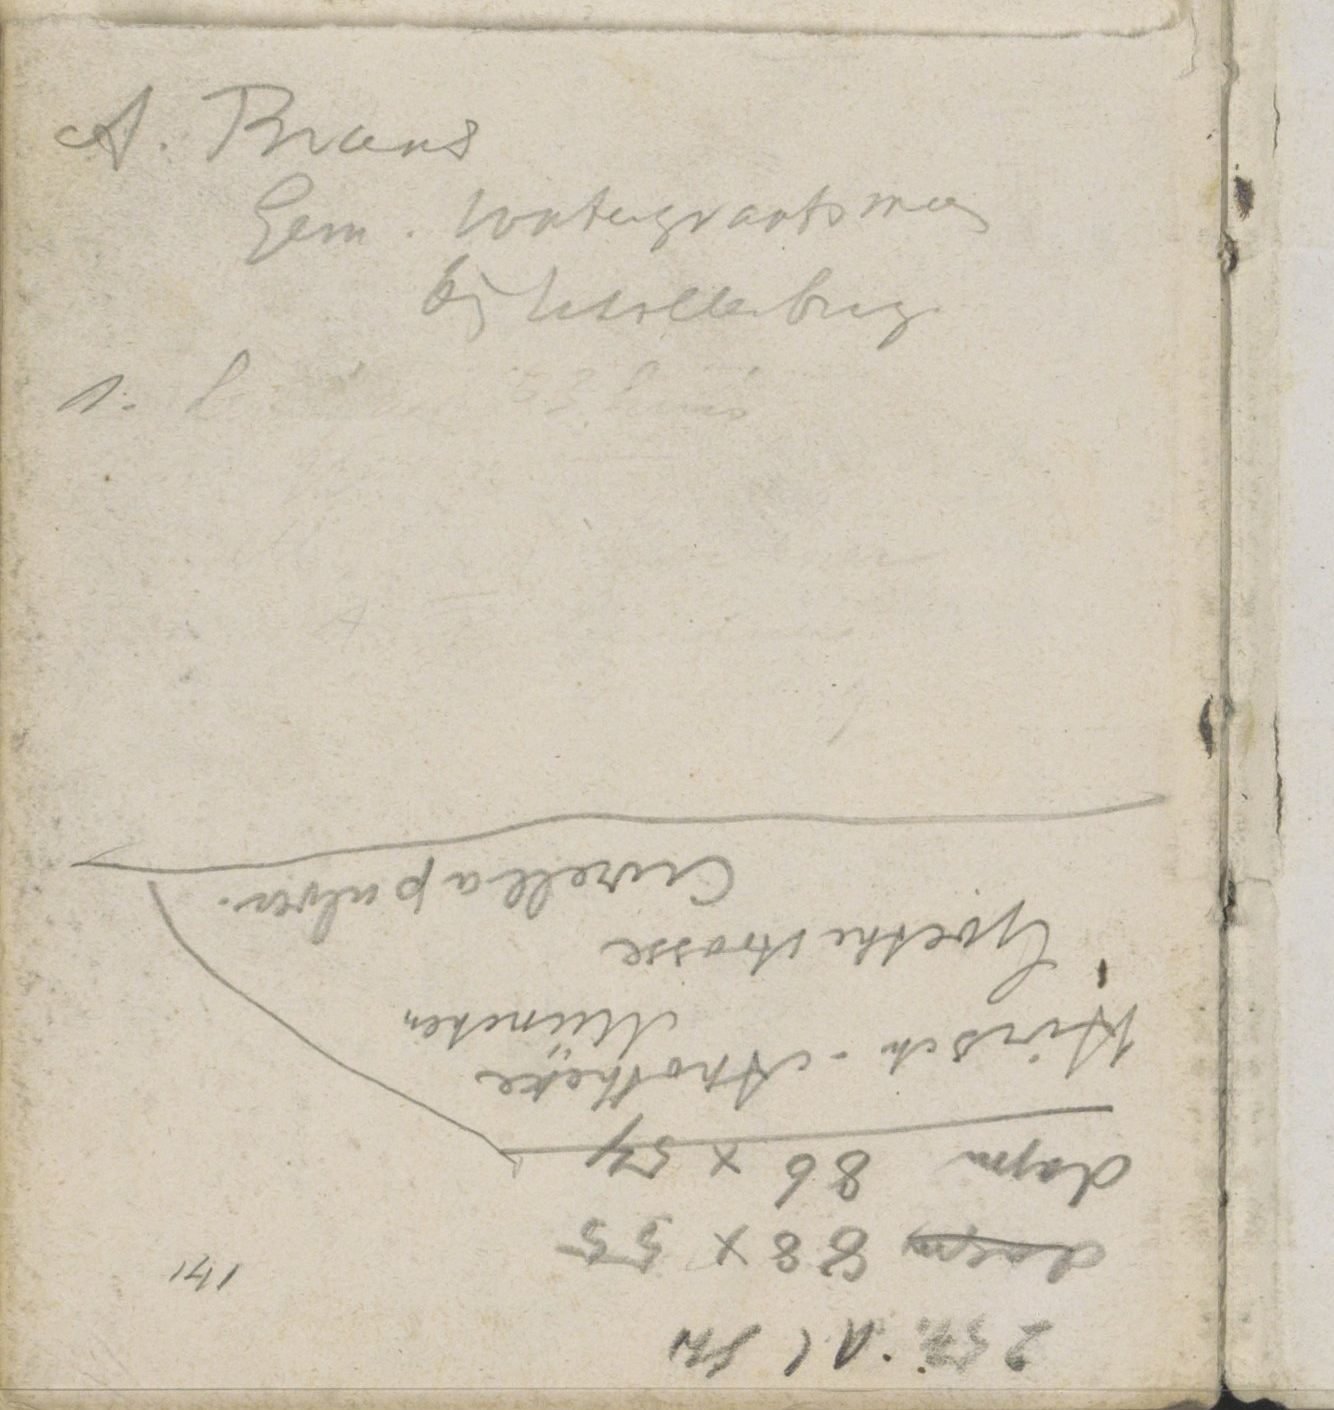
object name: sketchbook leaf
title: Annotaties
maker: george hendrik breitner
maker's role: draughtsman, painter, print maker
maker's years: 1857-1923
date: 1907-1909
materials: chalk, paper, pencil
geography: amsterdam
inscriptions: annotation: ‘Hirsch-Apotheke/ München/ Goethestrasse/ Curellapulver’, annotation: ‘A. Brans/ Gem. Watergraafsmeer/ bij Letselerbrug[?]’, annotation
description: Aantekeningen. Pagina 91 uit een schetsboek met 46 bladen vervaardigd te Antwerpen, Gent en Amsterdam.